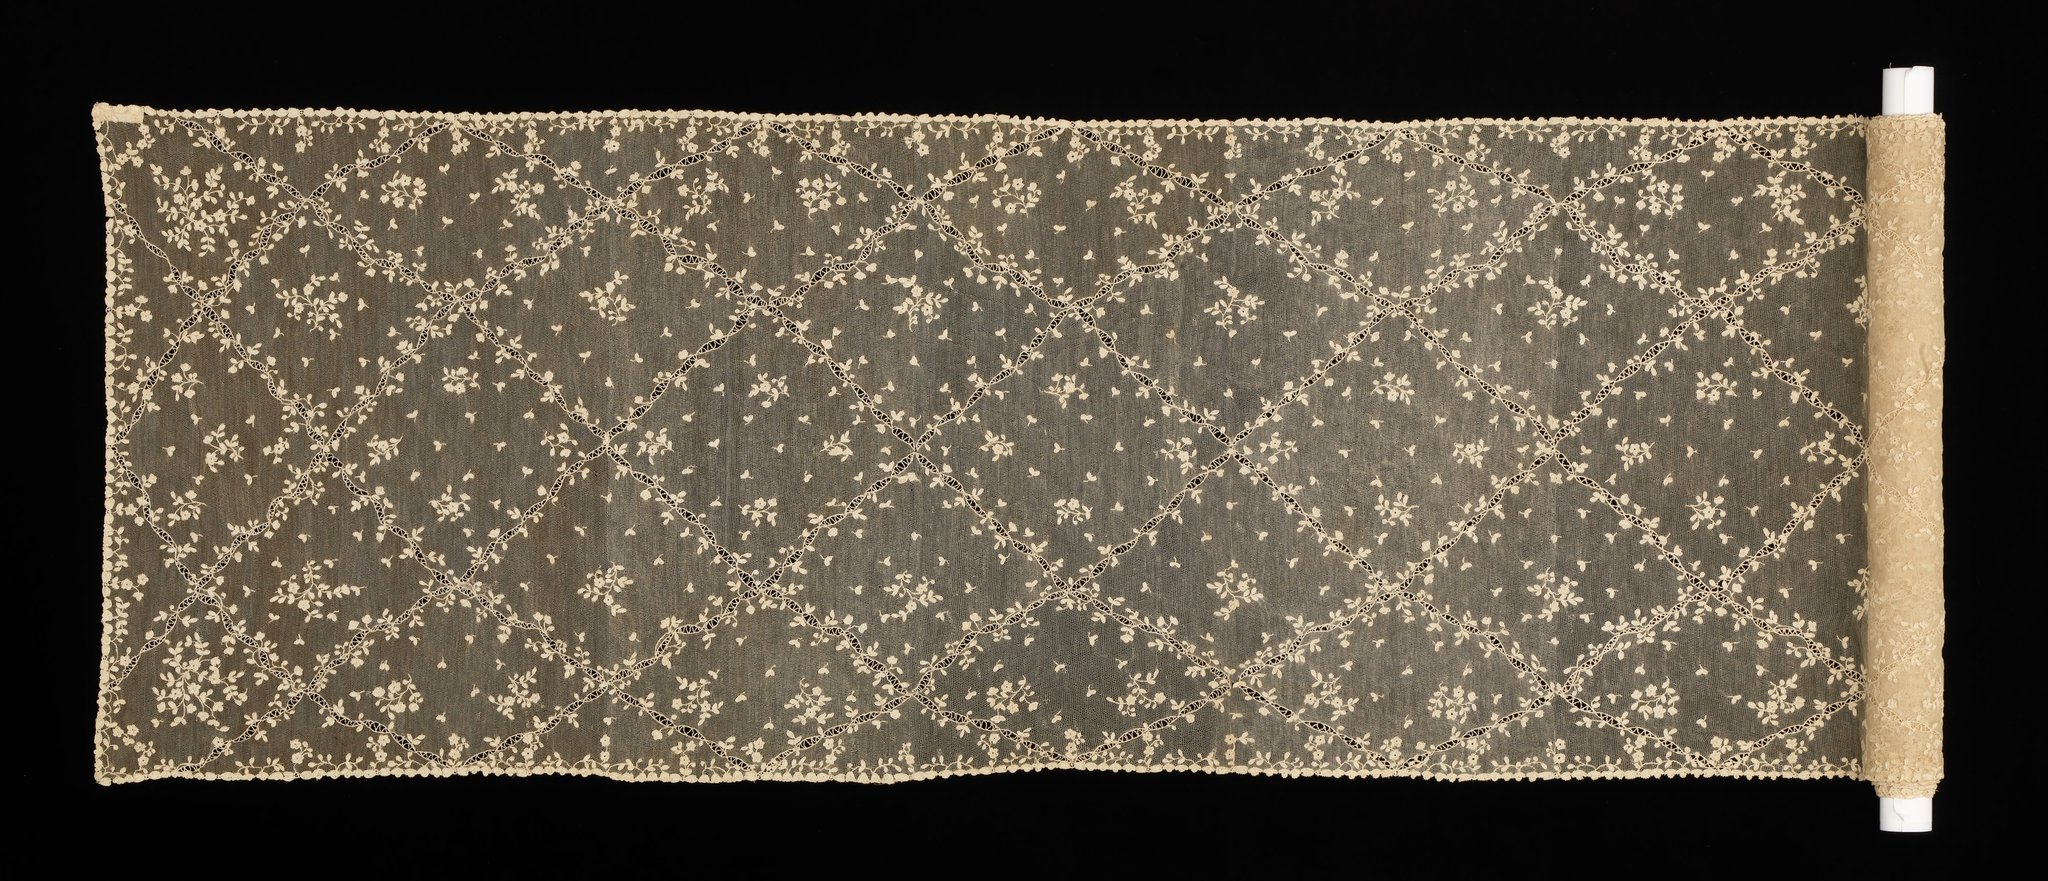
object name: stole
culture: french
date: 1790-1810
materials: linen